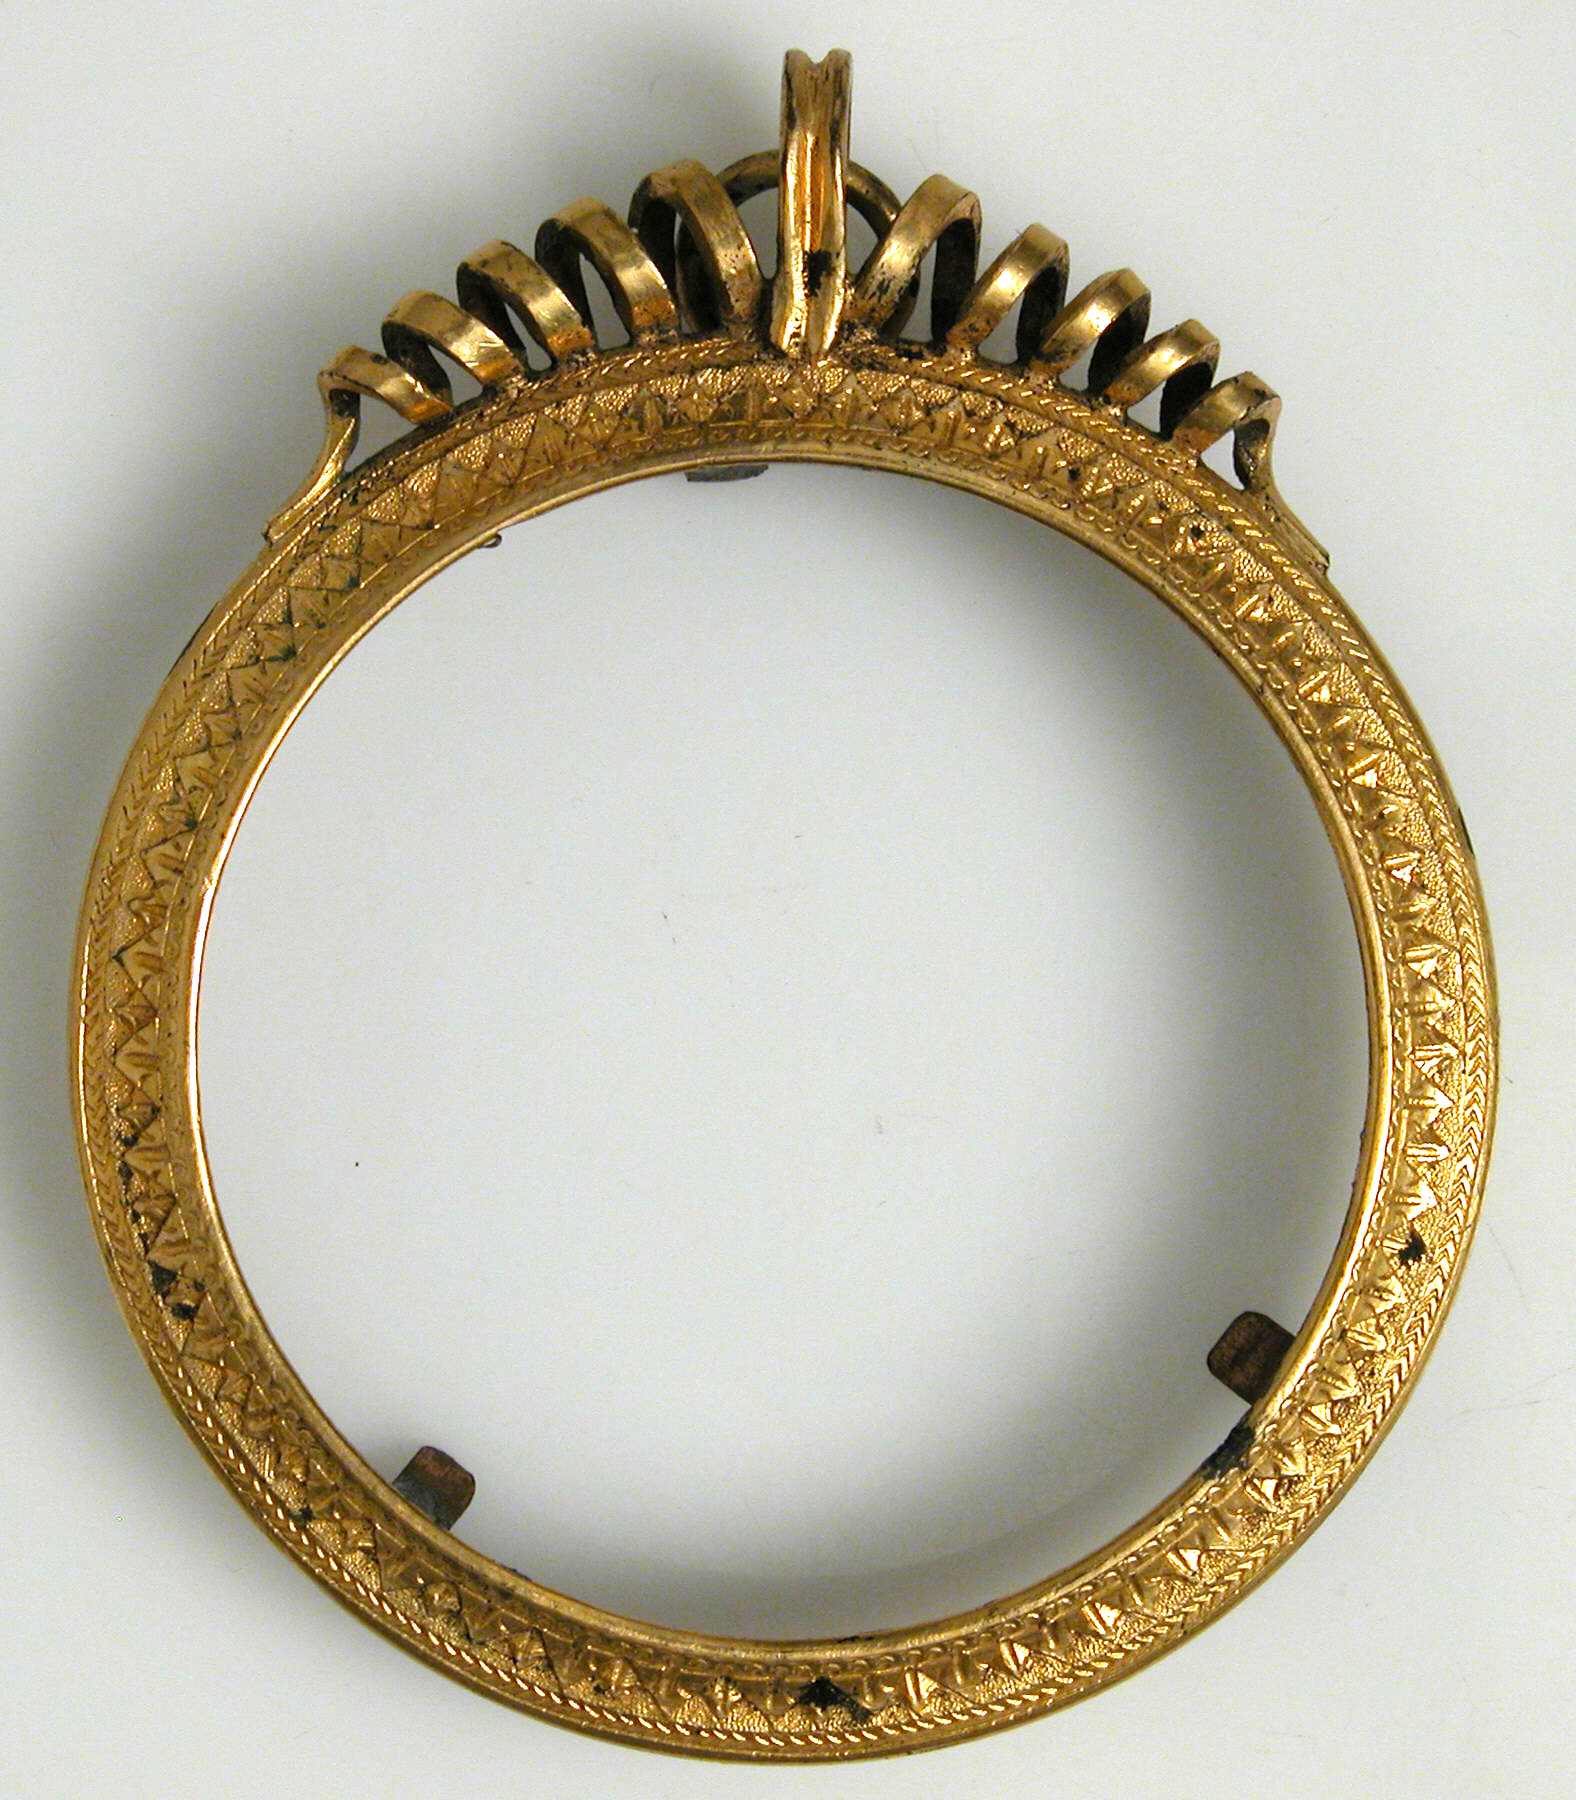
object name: medallion frame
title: Frame, Medallion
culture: british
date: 1701-1800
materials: copper alloy, gilt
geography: egypt